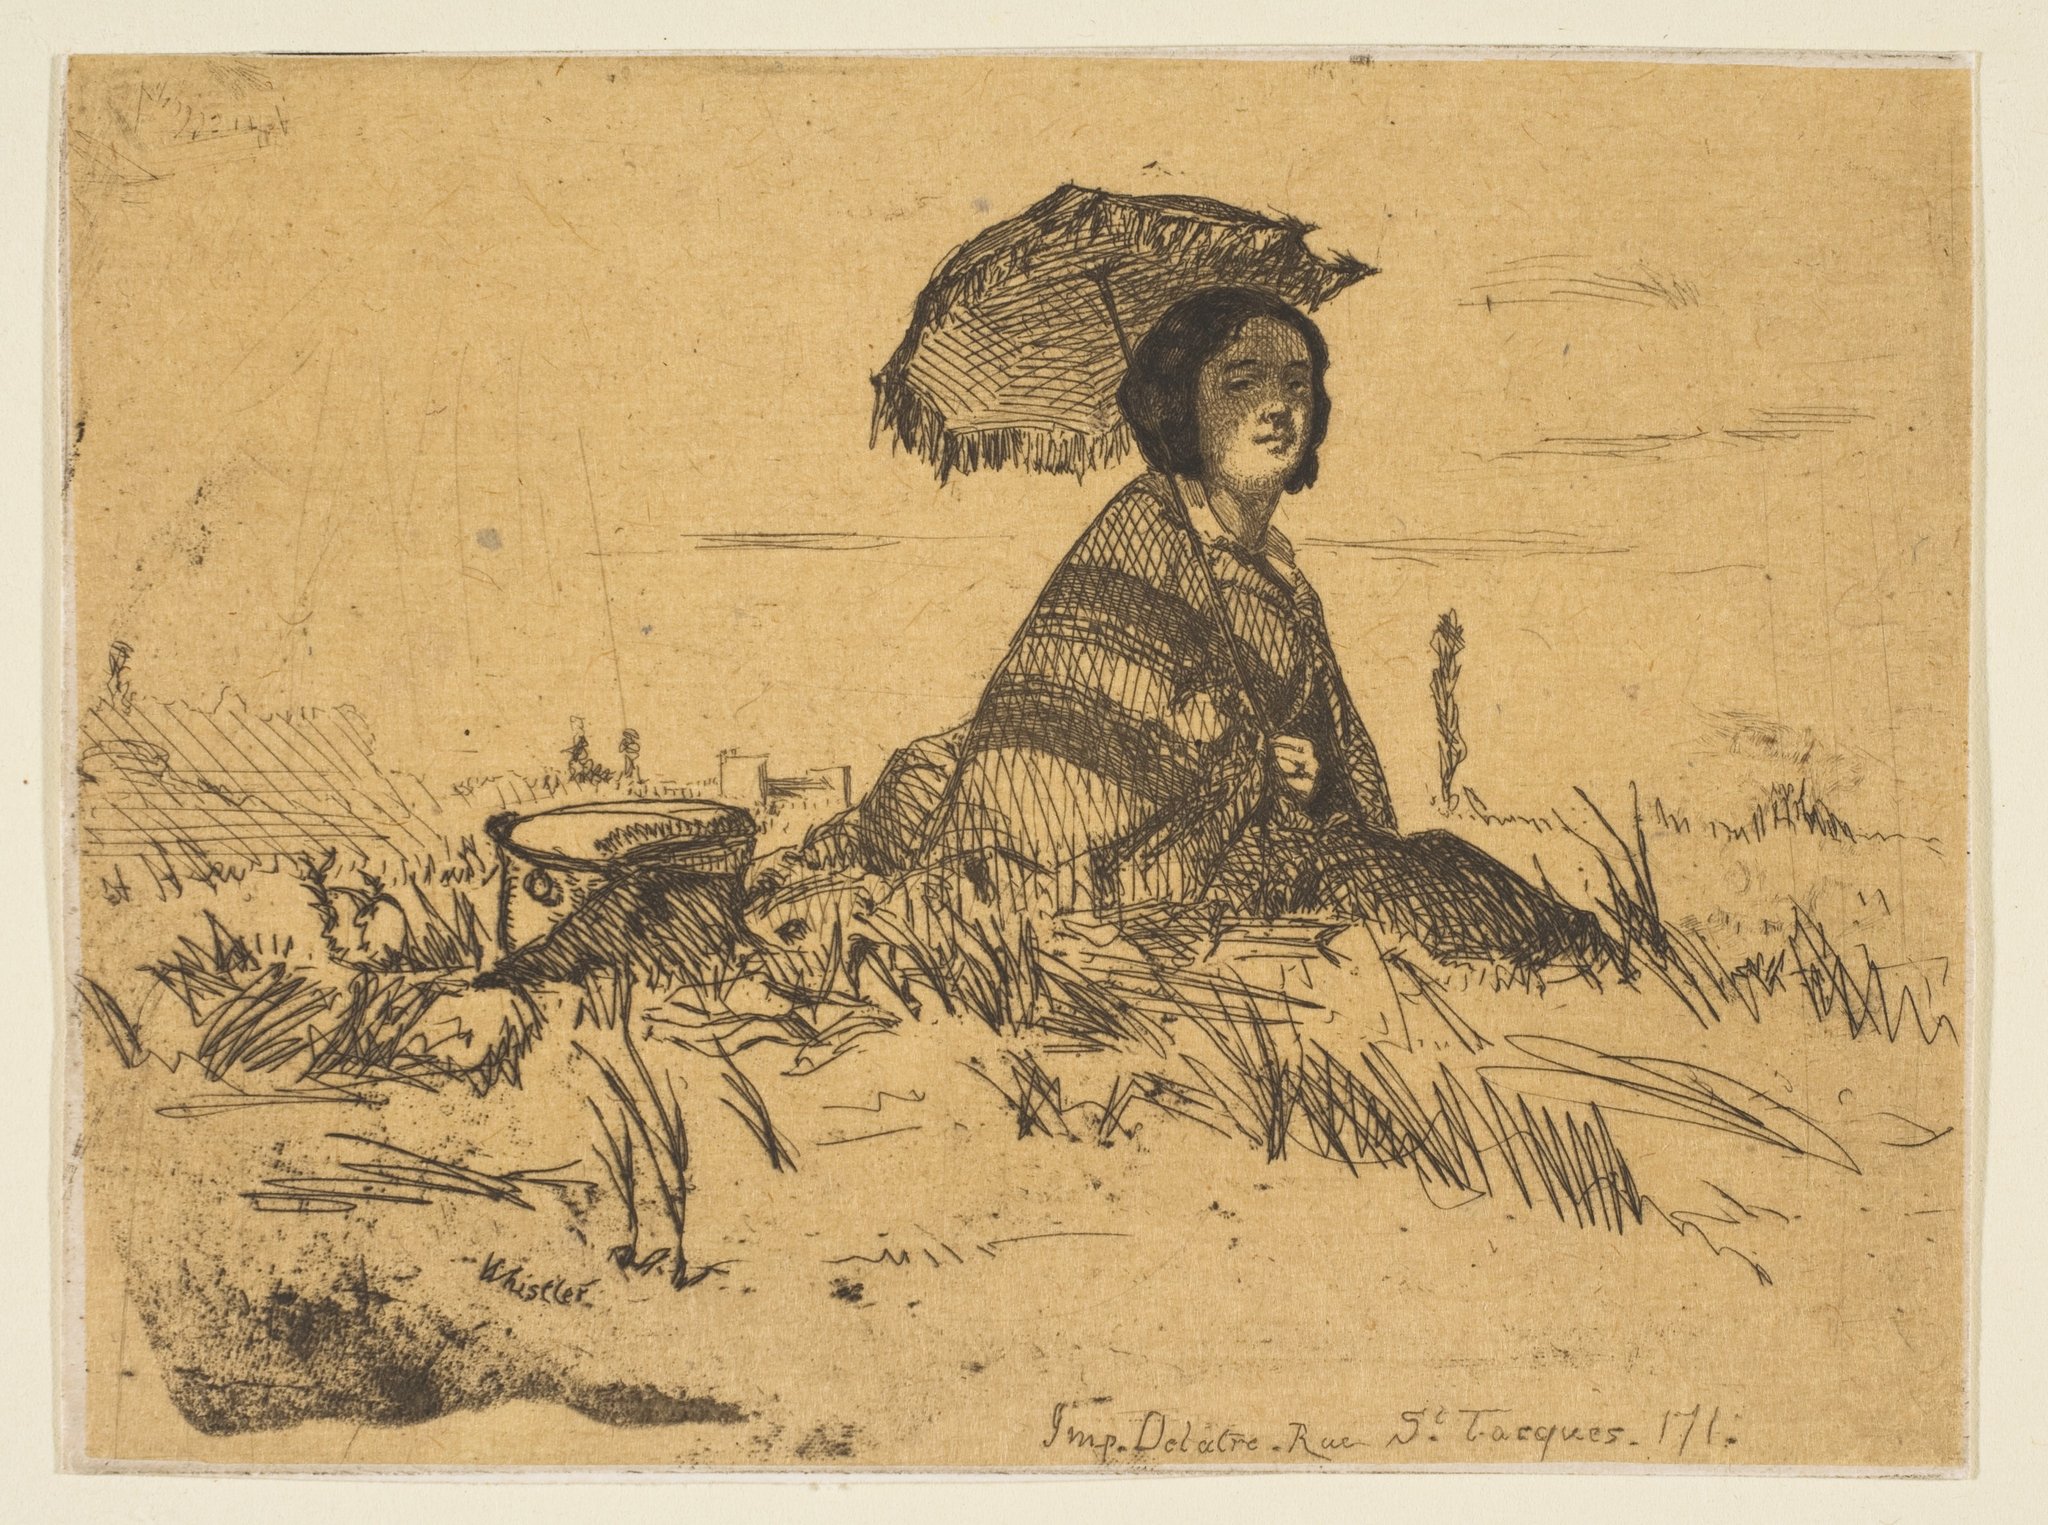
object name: print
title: En plein soleil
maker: james mcneill whistler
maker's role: artist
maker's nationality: american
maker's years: 1834-1903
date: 1858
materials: chine, paper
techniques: printmaking, etching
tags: women,parasols